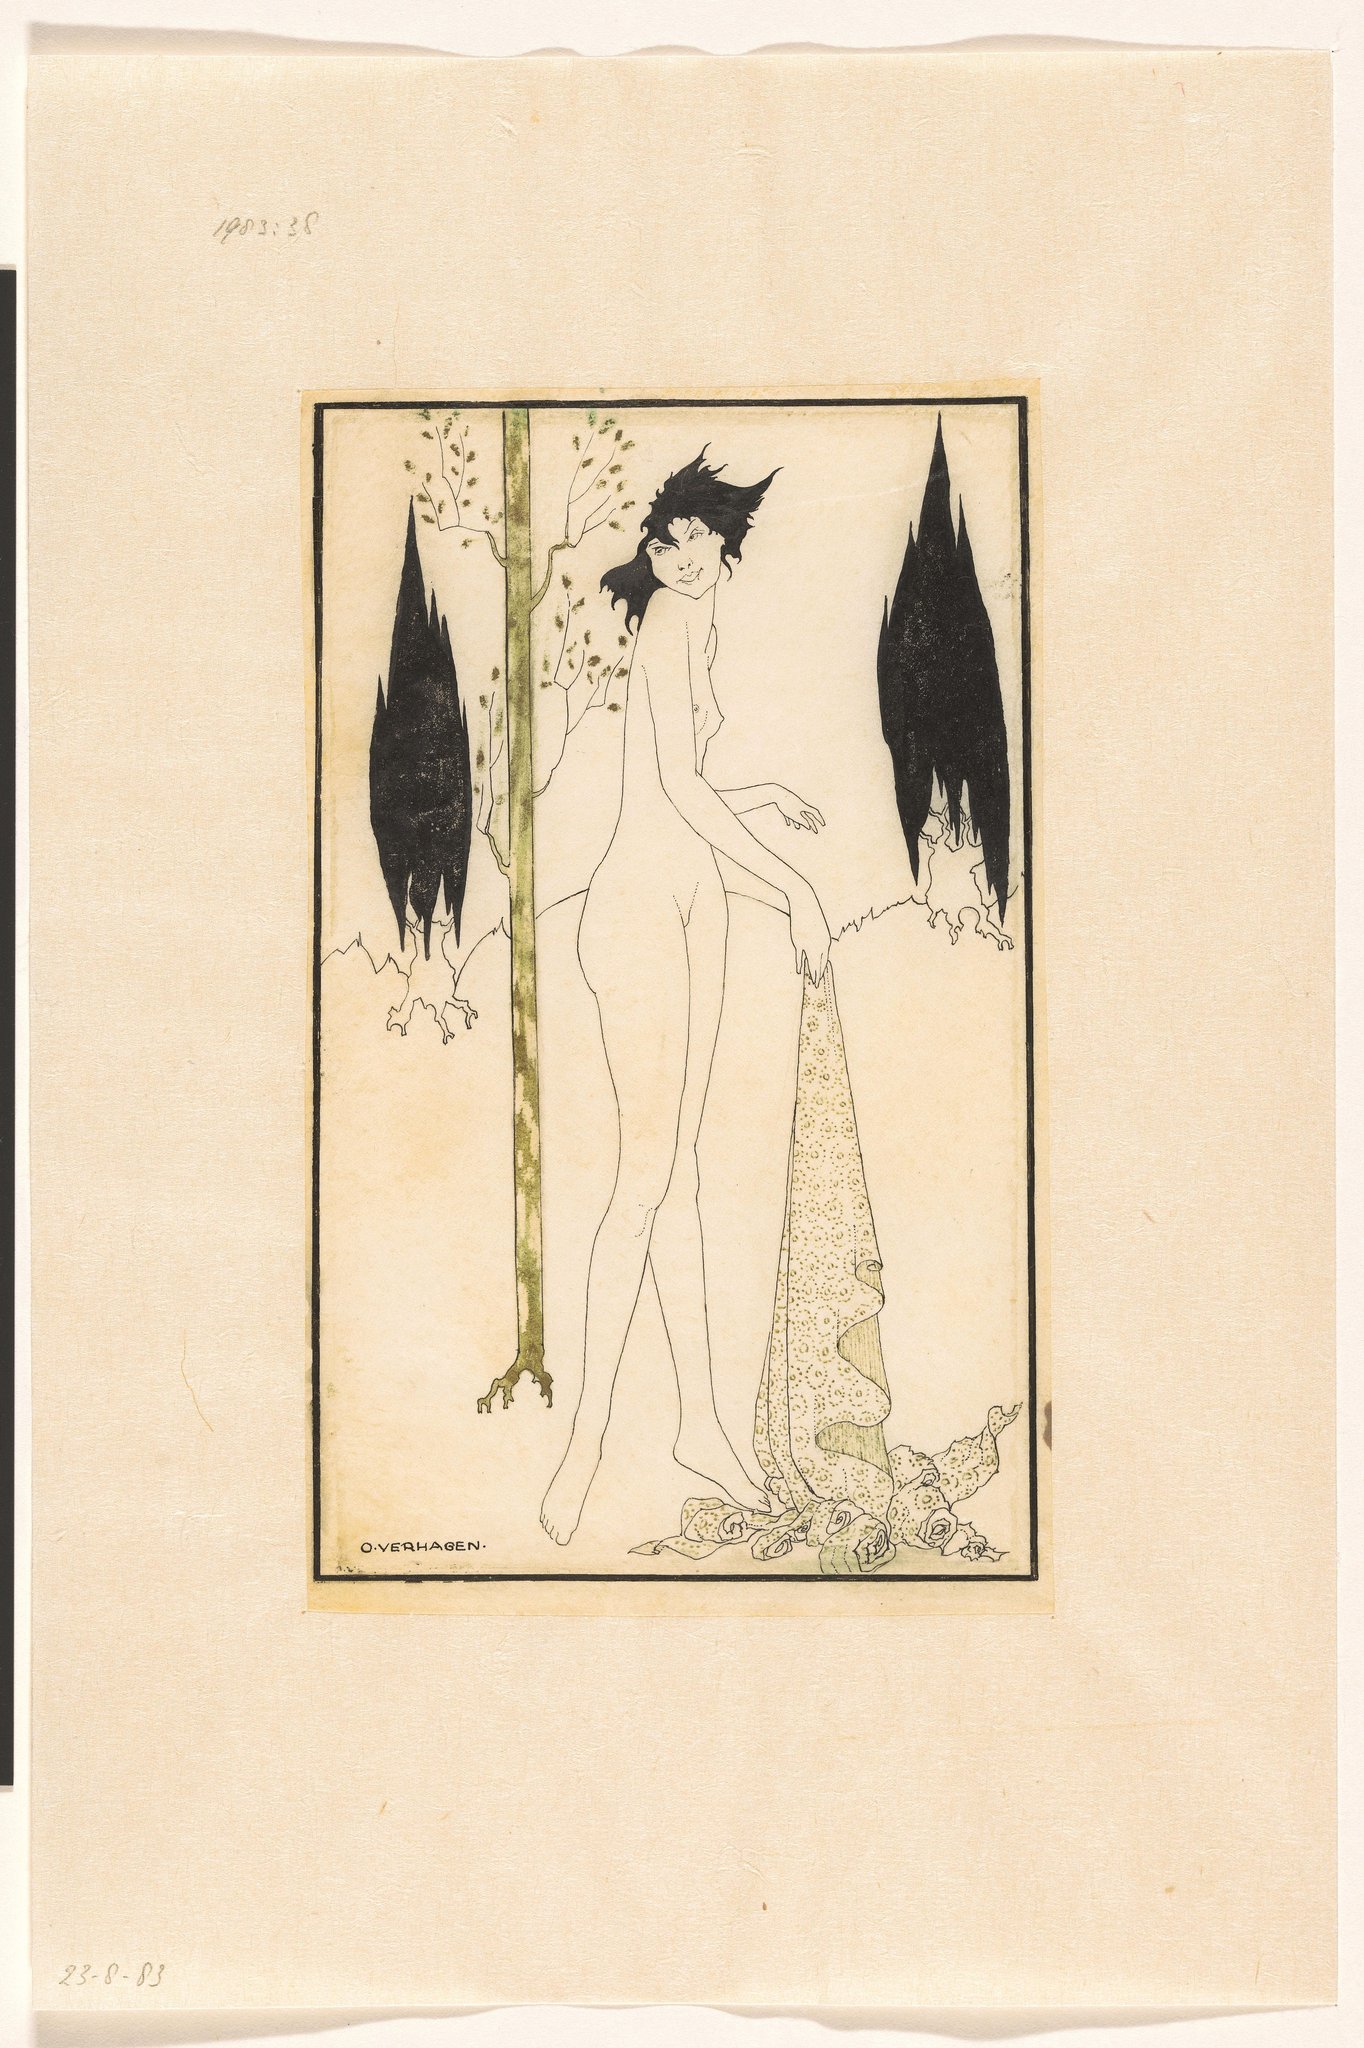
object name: boekillustratie ontwerp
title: Staande naakte jonge vrouw tussen bomen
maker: otto verhagen (i)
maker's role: draughtsman, print maker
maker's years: 1885-1951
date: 1918-1920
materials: paint, ink, parchment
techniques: brush, pen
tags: (evers, allraune) specific works of literature (with author, title)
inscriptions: collector's mark: Lugt 2228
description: Ontwerp voor een boekillustratie bij 'Alraune' van Evers.